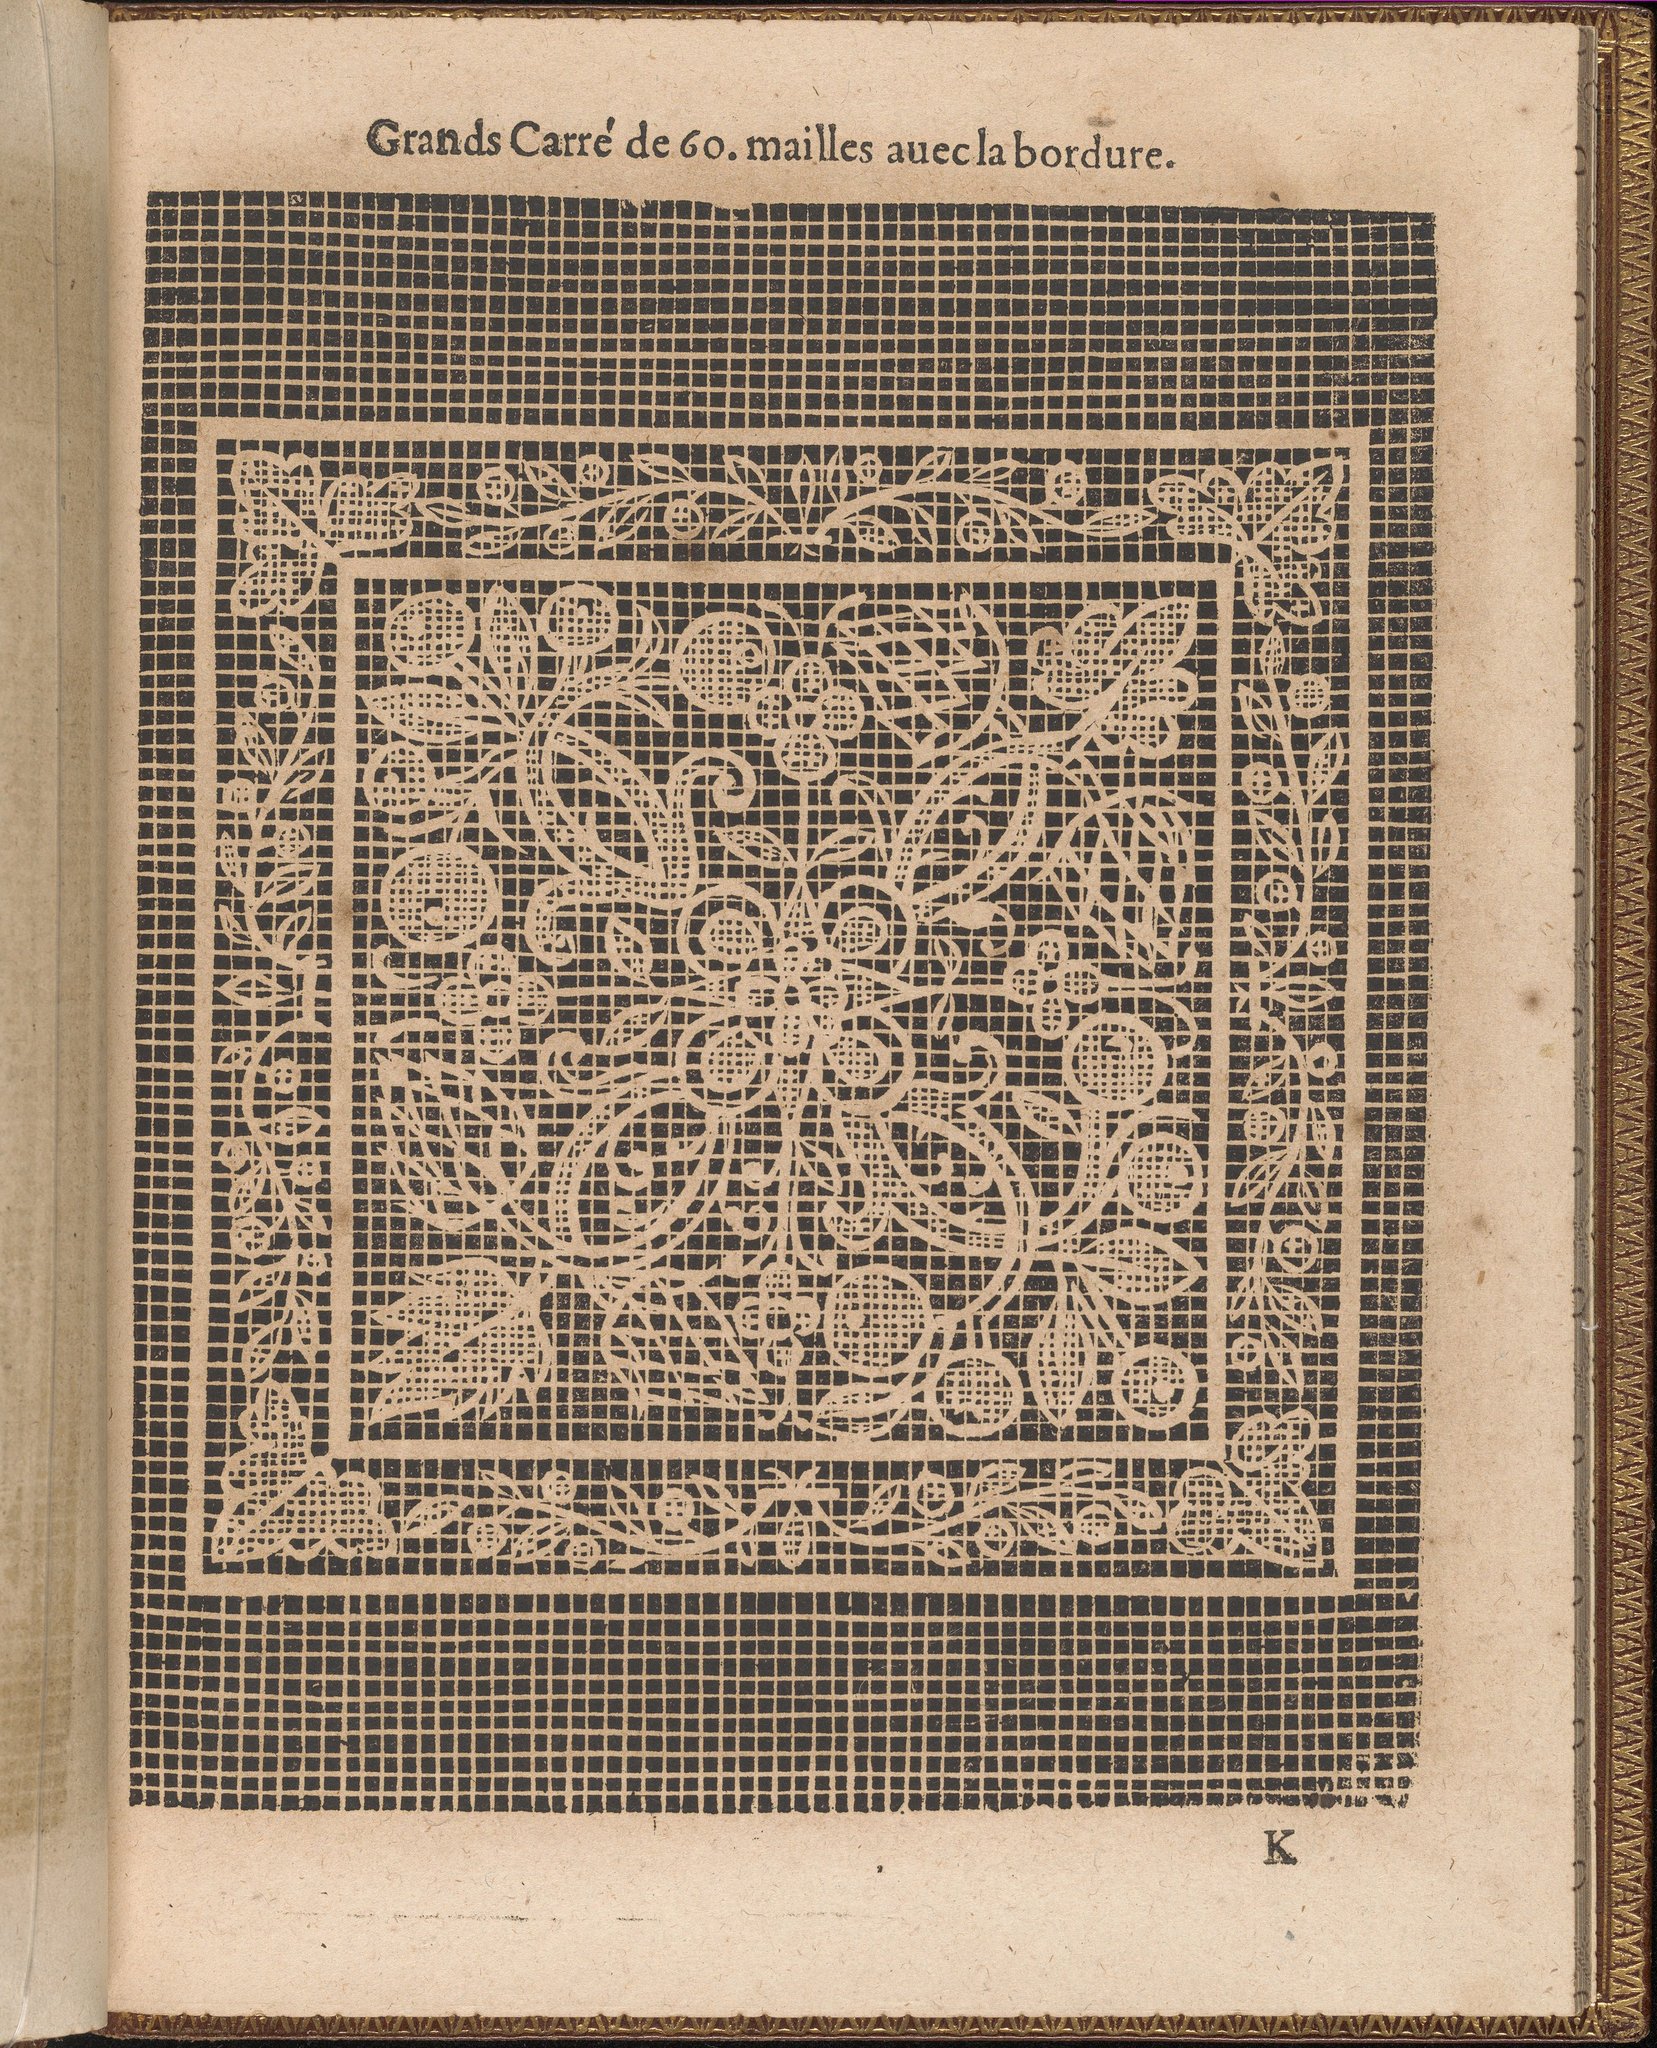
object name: book print ornament architecture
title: La Pratique de l'Aiguille, page 36 (recto)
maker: matthias mignerak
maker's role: author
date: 1605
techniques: woodcut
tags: ornament